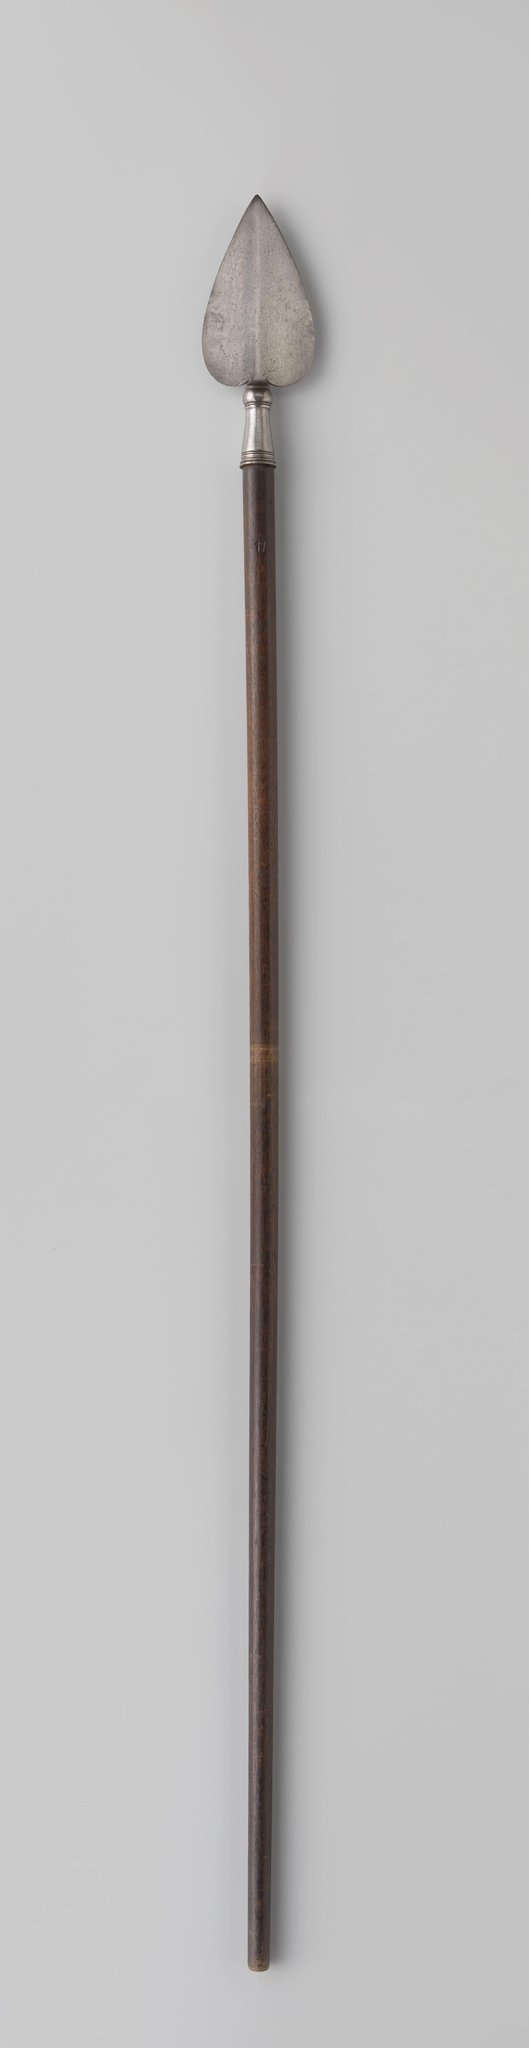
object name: pike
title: IJzeren piek met koperen band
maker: Anonymous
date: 1600-1699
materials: iron, wood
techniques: forging, riveted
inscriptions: mark: ‘17’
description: Officierspiek, stokwapen samengesteld uit een taps huis, met vier klinknagels aan de schacht bevestigd, een noeud-de-corps en een tweesnijdende kling met zeer conveze sneden.